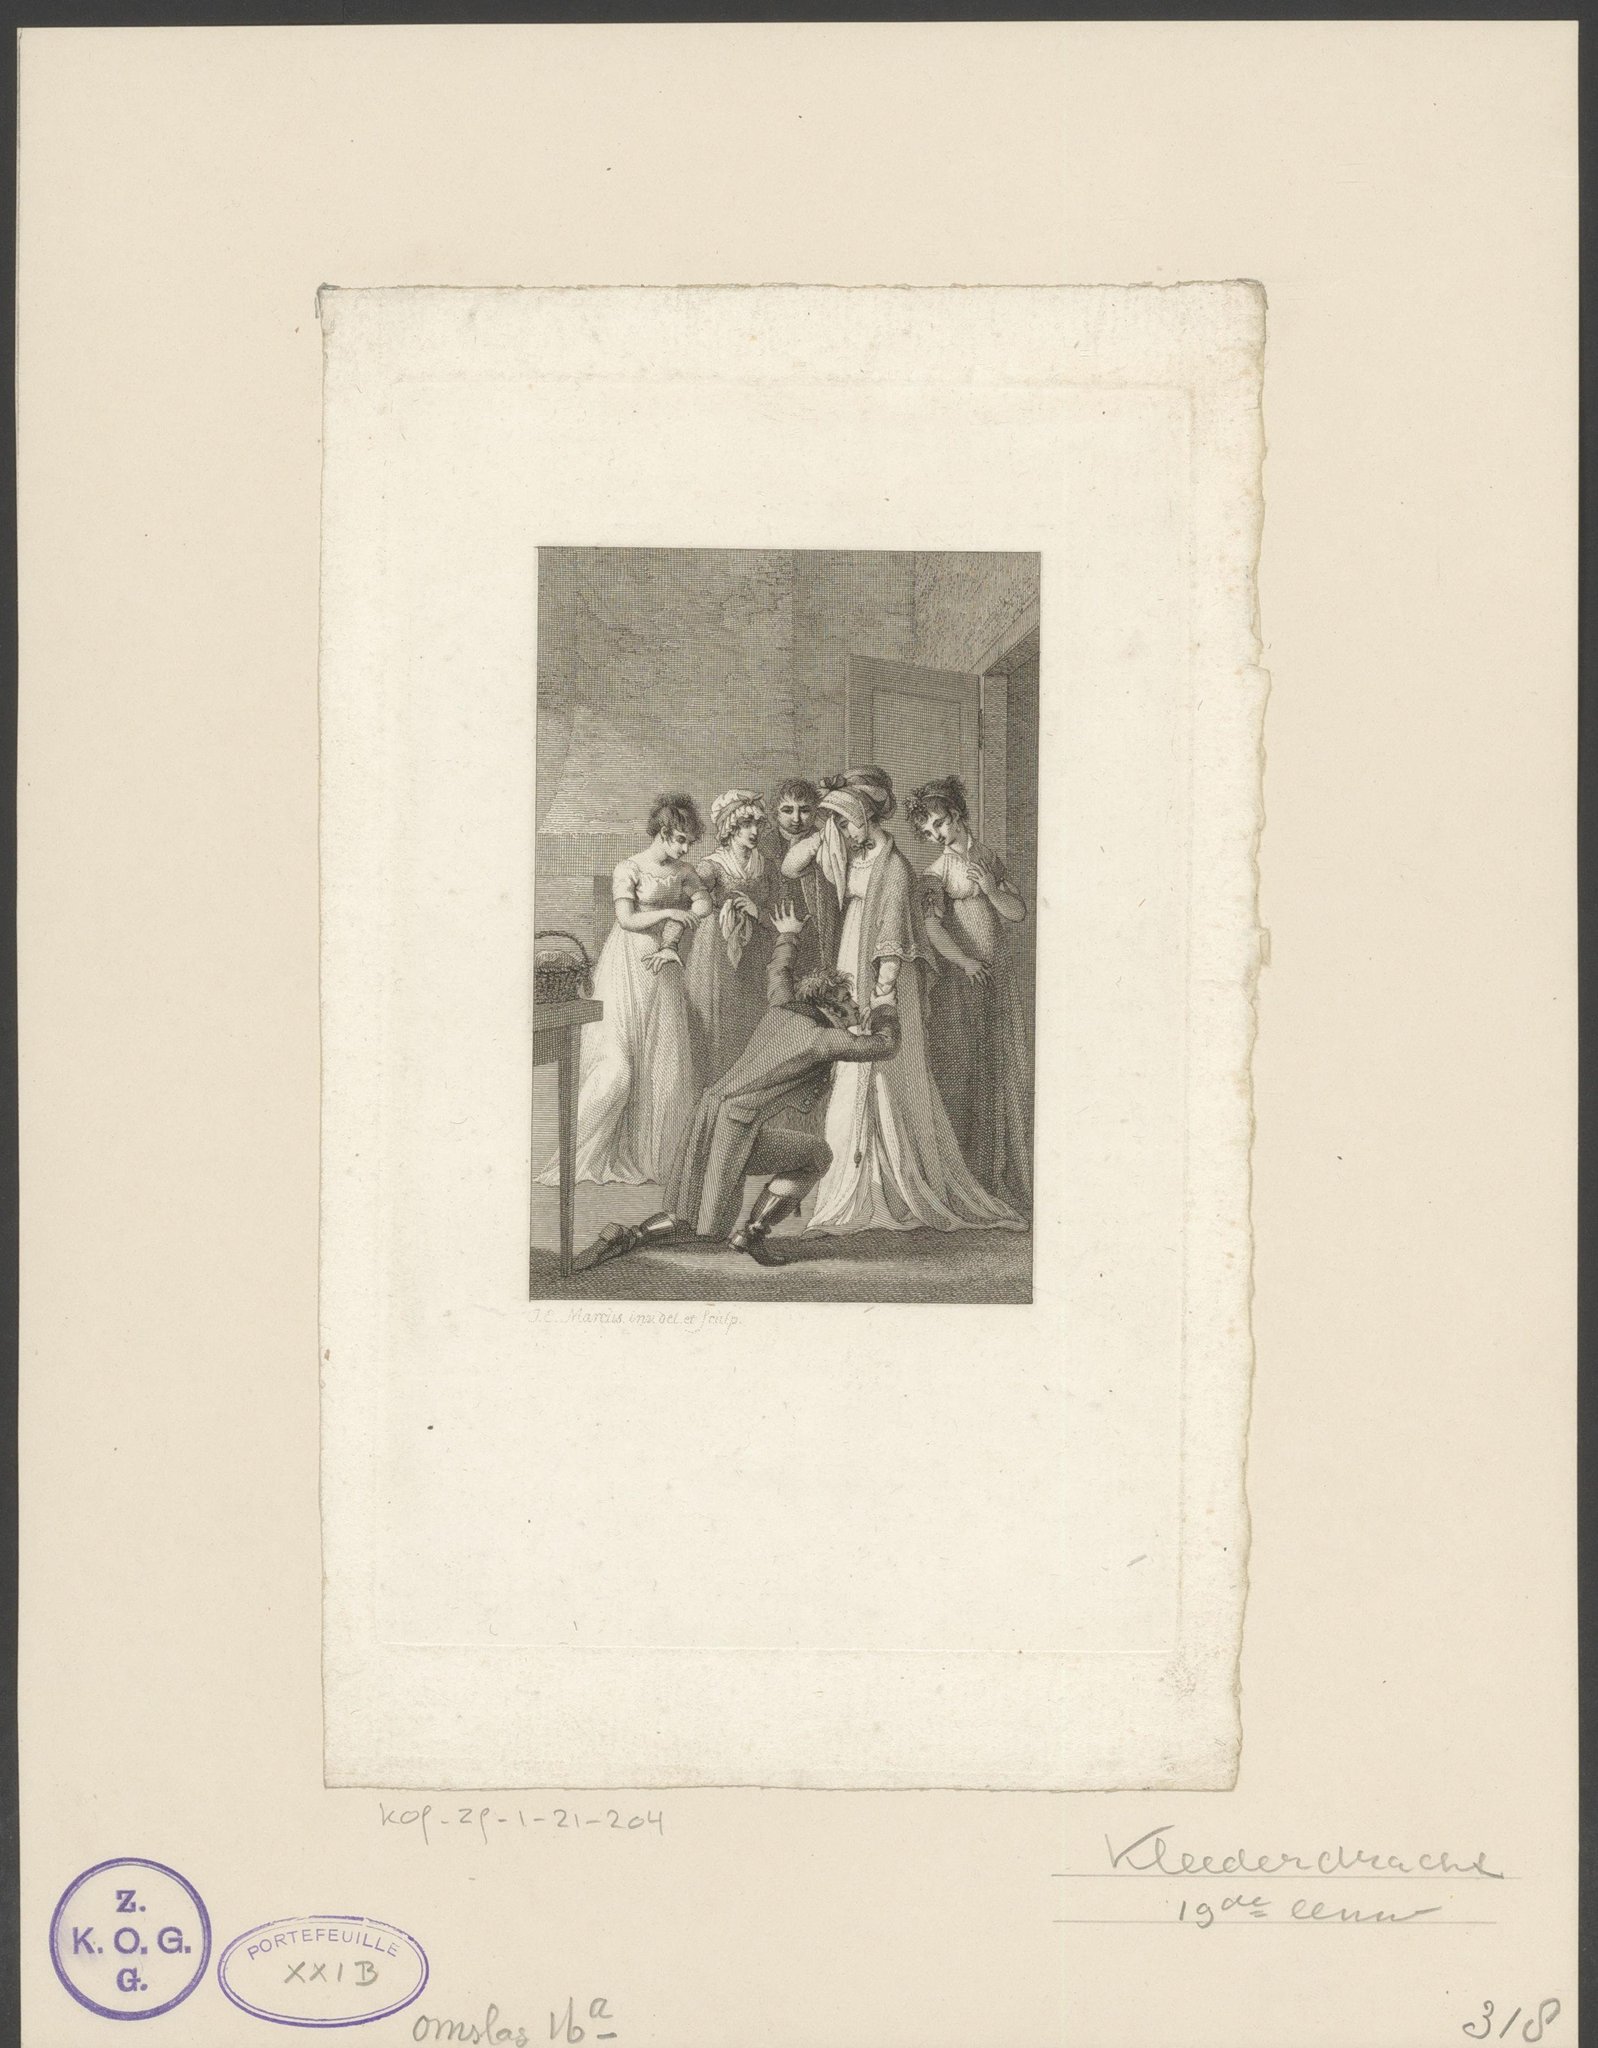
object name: print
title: Handkussende man bij een huilende vrouw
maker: jacob ernst marcus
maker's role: draughtsman, print maker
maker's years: 1774-1826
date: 1804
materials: paper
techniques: etching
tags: weeping, kissing the hand (lovers)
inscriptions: stamp, collector's mark: Lugt 1641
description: In een interieur bij een deuropening knielt een man bij een geëmotioneerde vrouw en geeft haar een handkus. In de kamer staan nog drie vrouwen en een man. Scène uit het toneelstuk: De zelfbeheersching van August Wilhelm Iffland. Rechtsonder gemerkt: Ve. Bedr. XVIe Toon. Onderwerpsrubrieken binnen de Atlas Zeden en Gewoonten: Zeden en Gewoonten in Engeren Zin, De Kleeding, Kleederdrachten (tijdvakken), Het begin der 19de eeuw. Mannen en vrouwen.